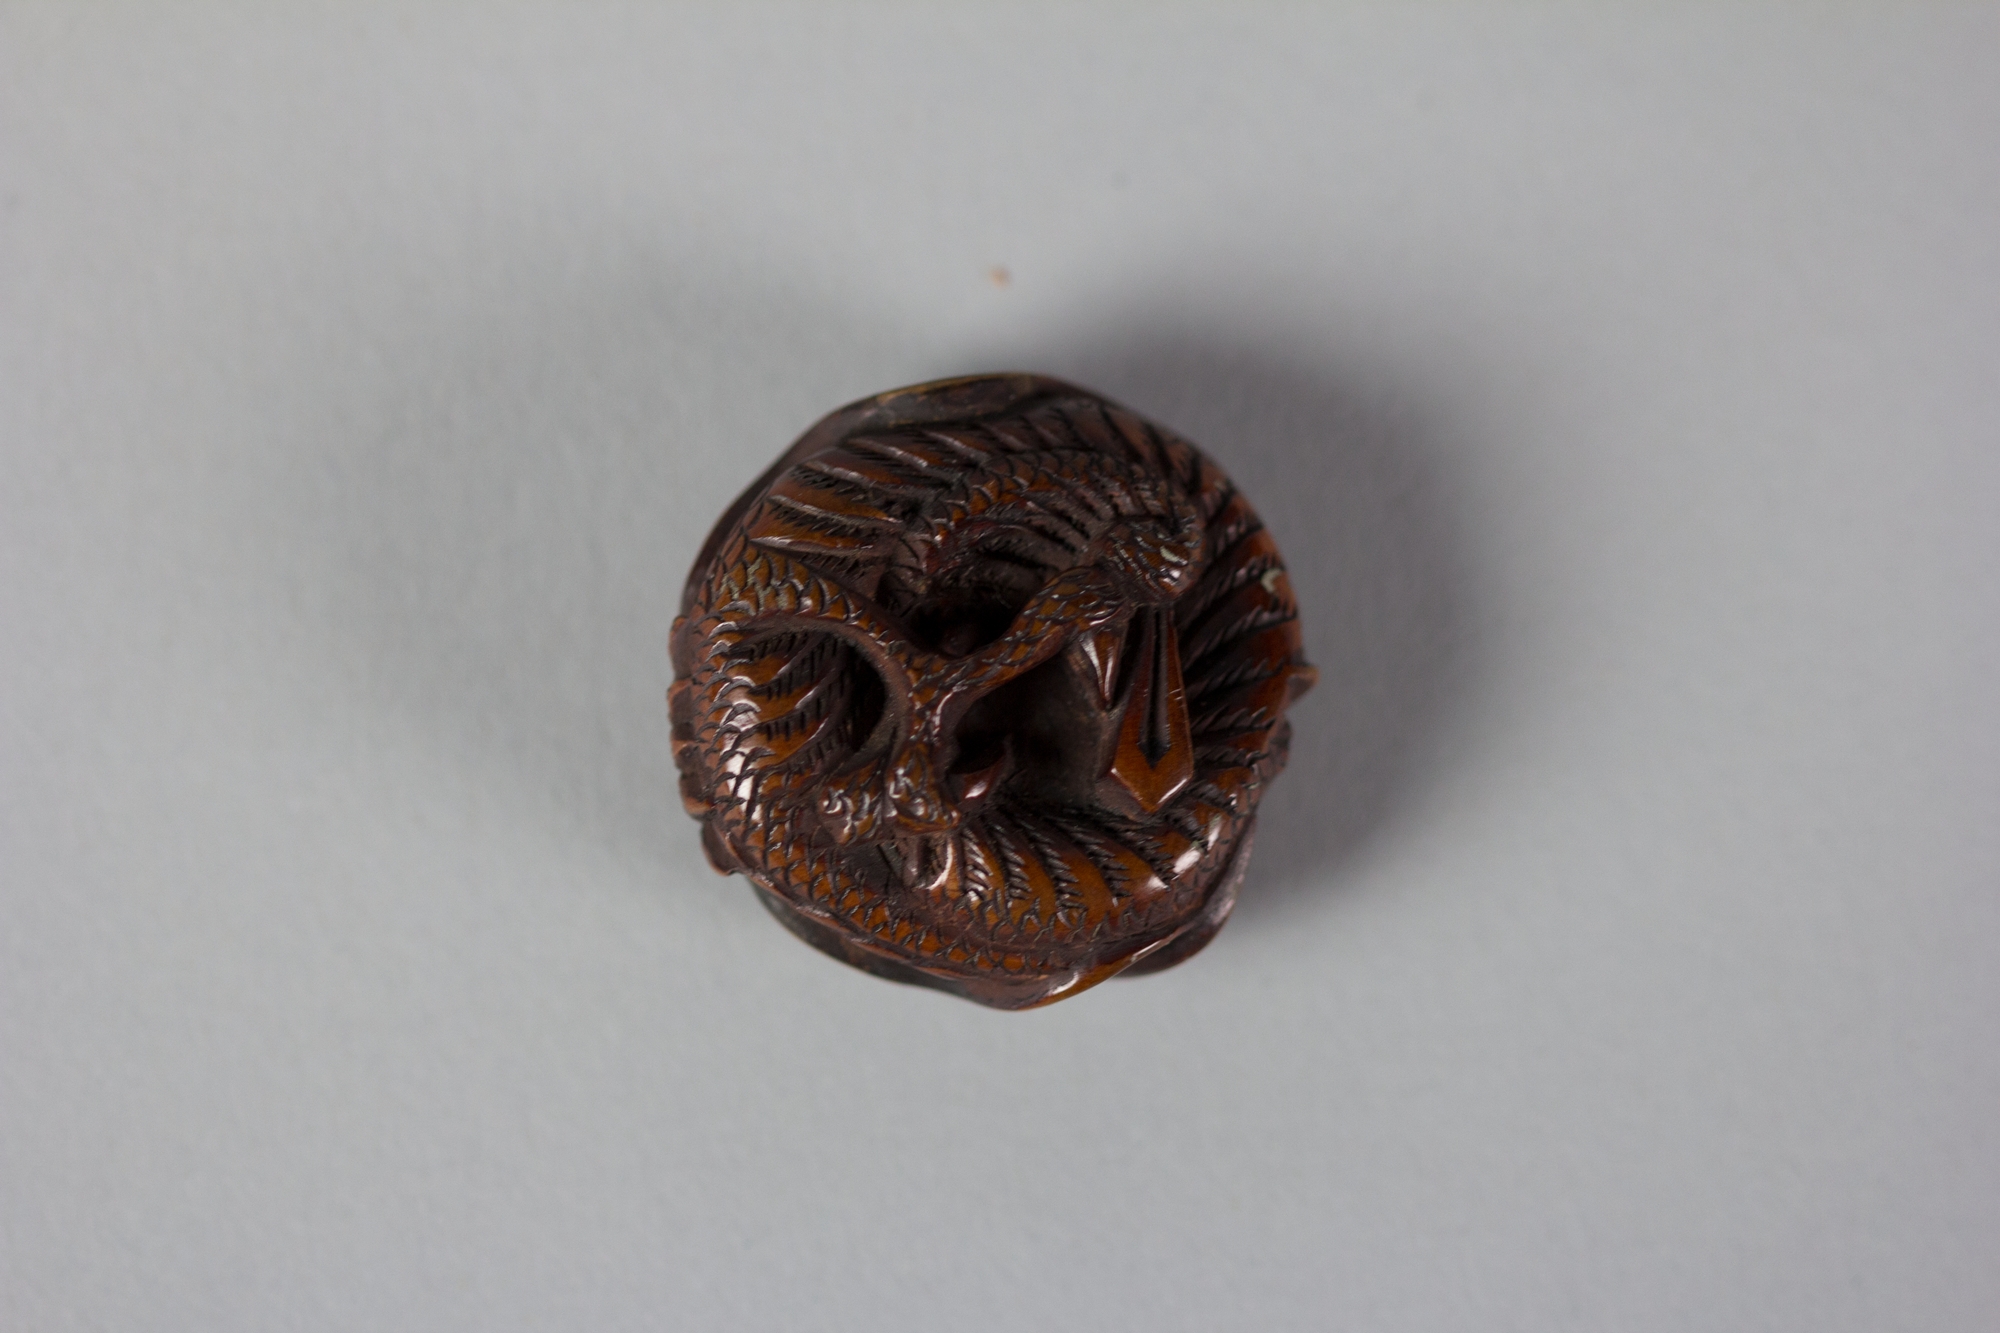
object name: netsuke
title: Netsuke of Coiled Dragon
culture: japanese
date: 1801-1900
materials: wood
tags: dragons